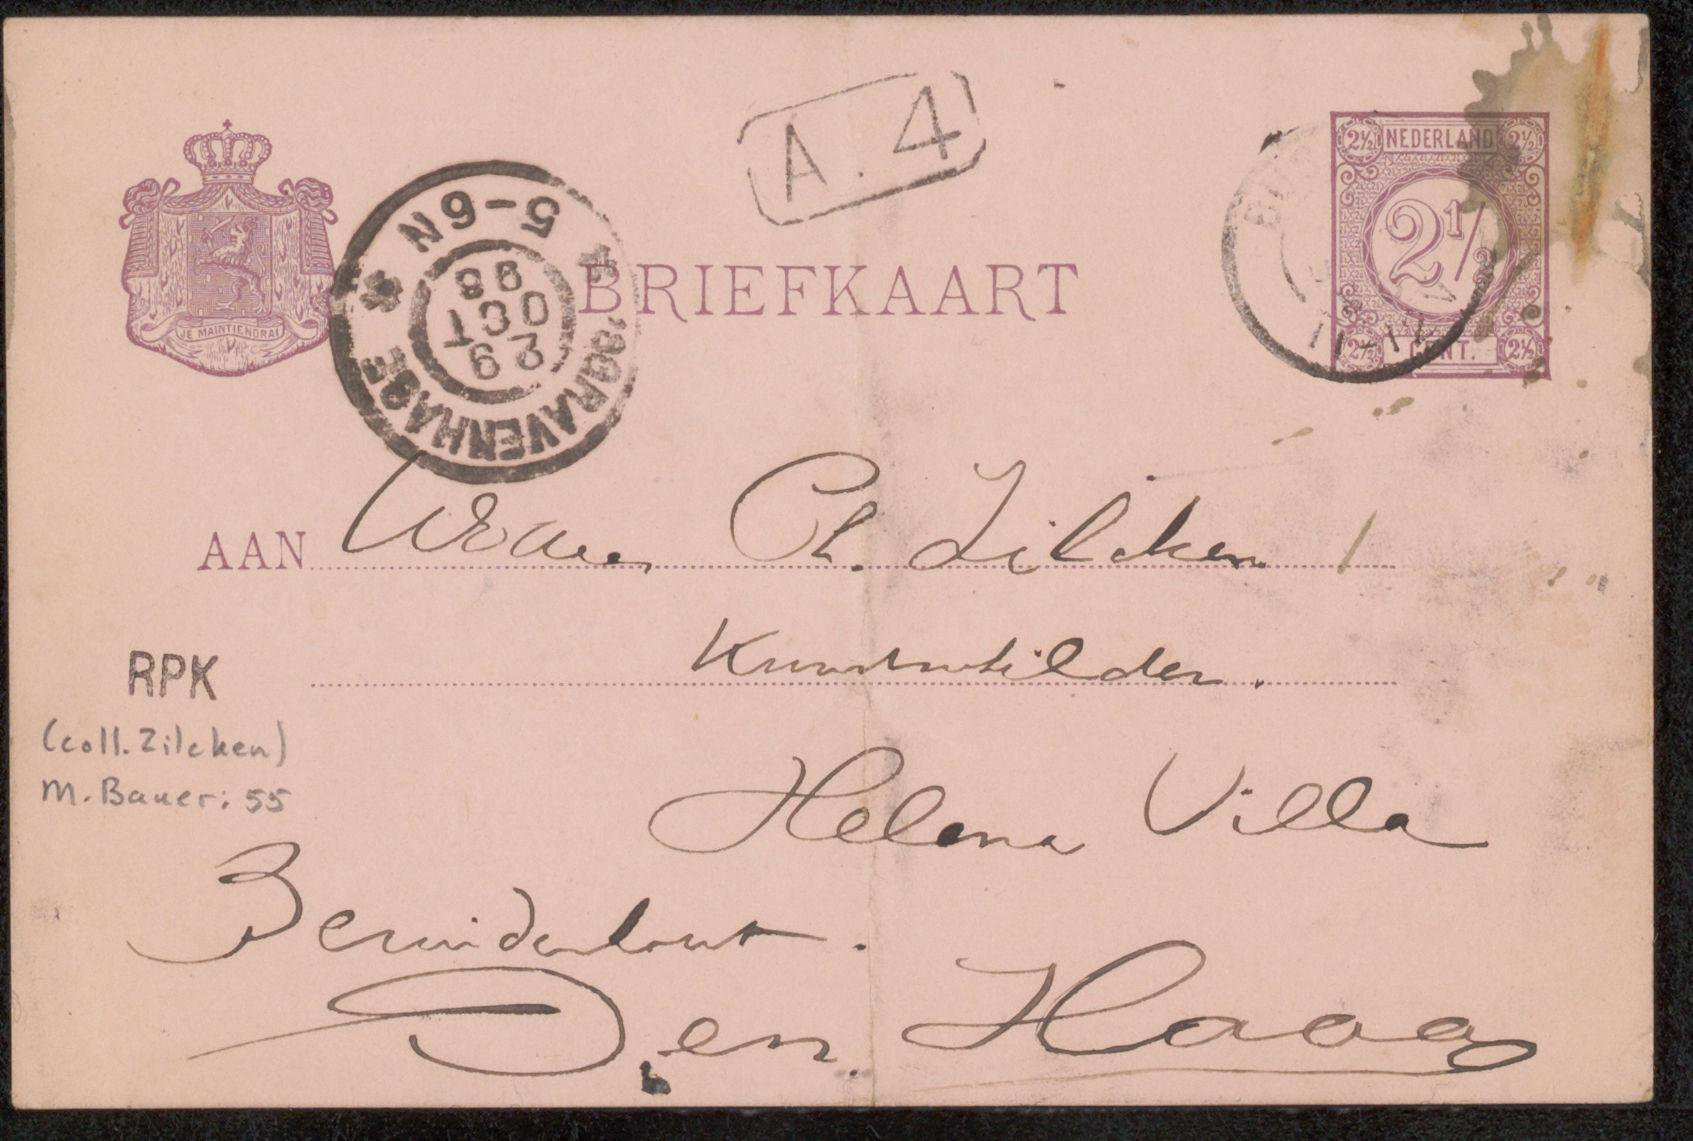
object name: postcard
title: Briefkaart aan Philip Zilcken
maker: marius bauer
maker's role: draughtsman, print maker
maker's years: 1867-1932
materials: cardboard, ink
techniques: pen, writing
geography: bussum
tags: middelburg, politician, pieter lodewijk tak, painter, philip zilcken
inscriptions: collector's mark: ‘RPK’